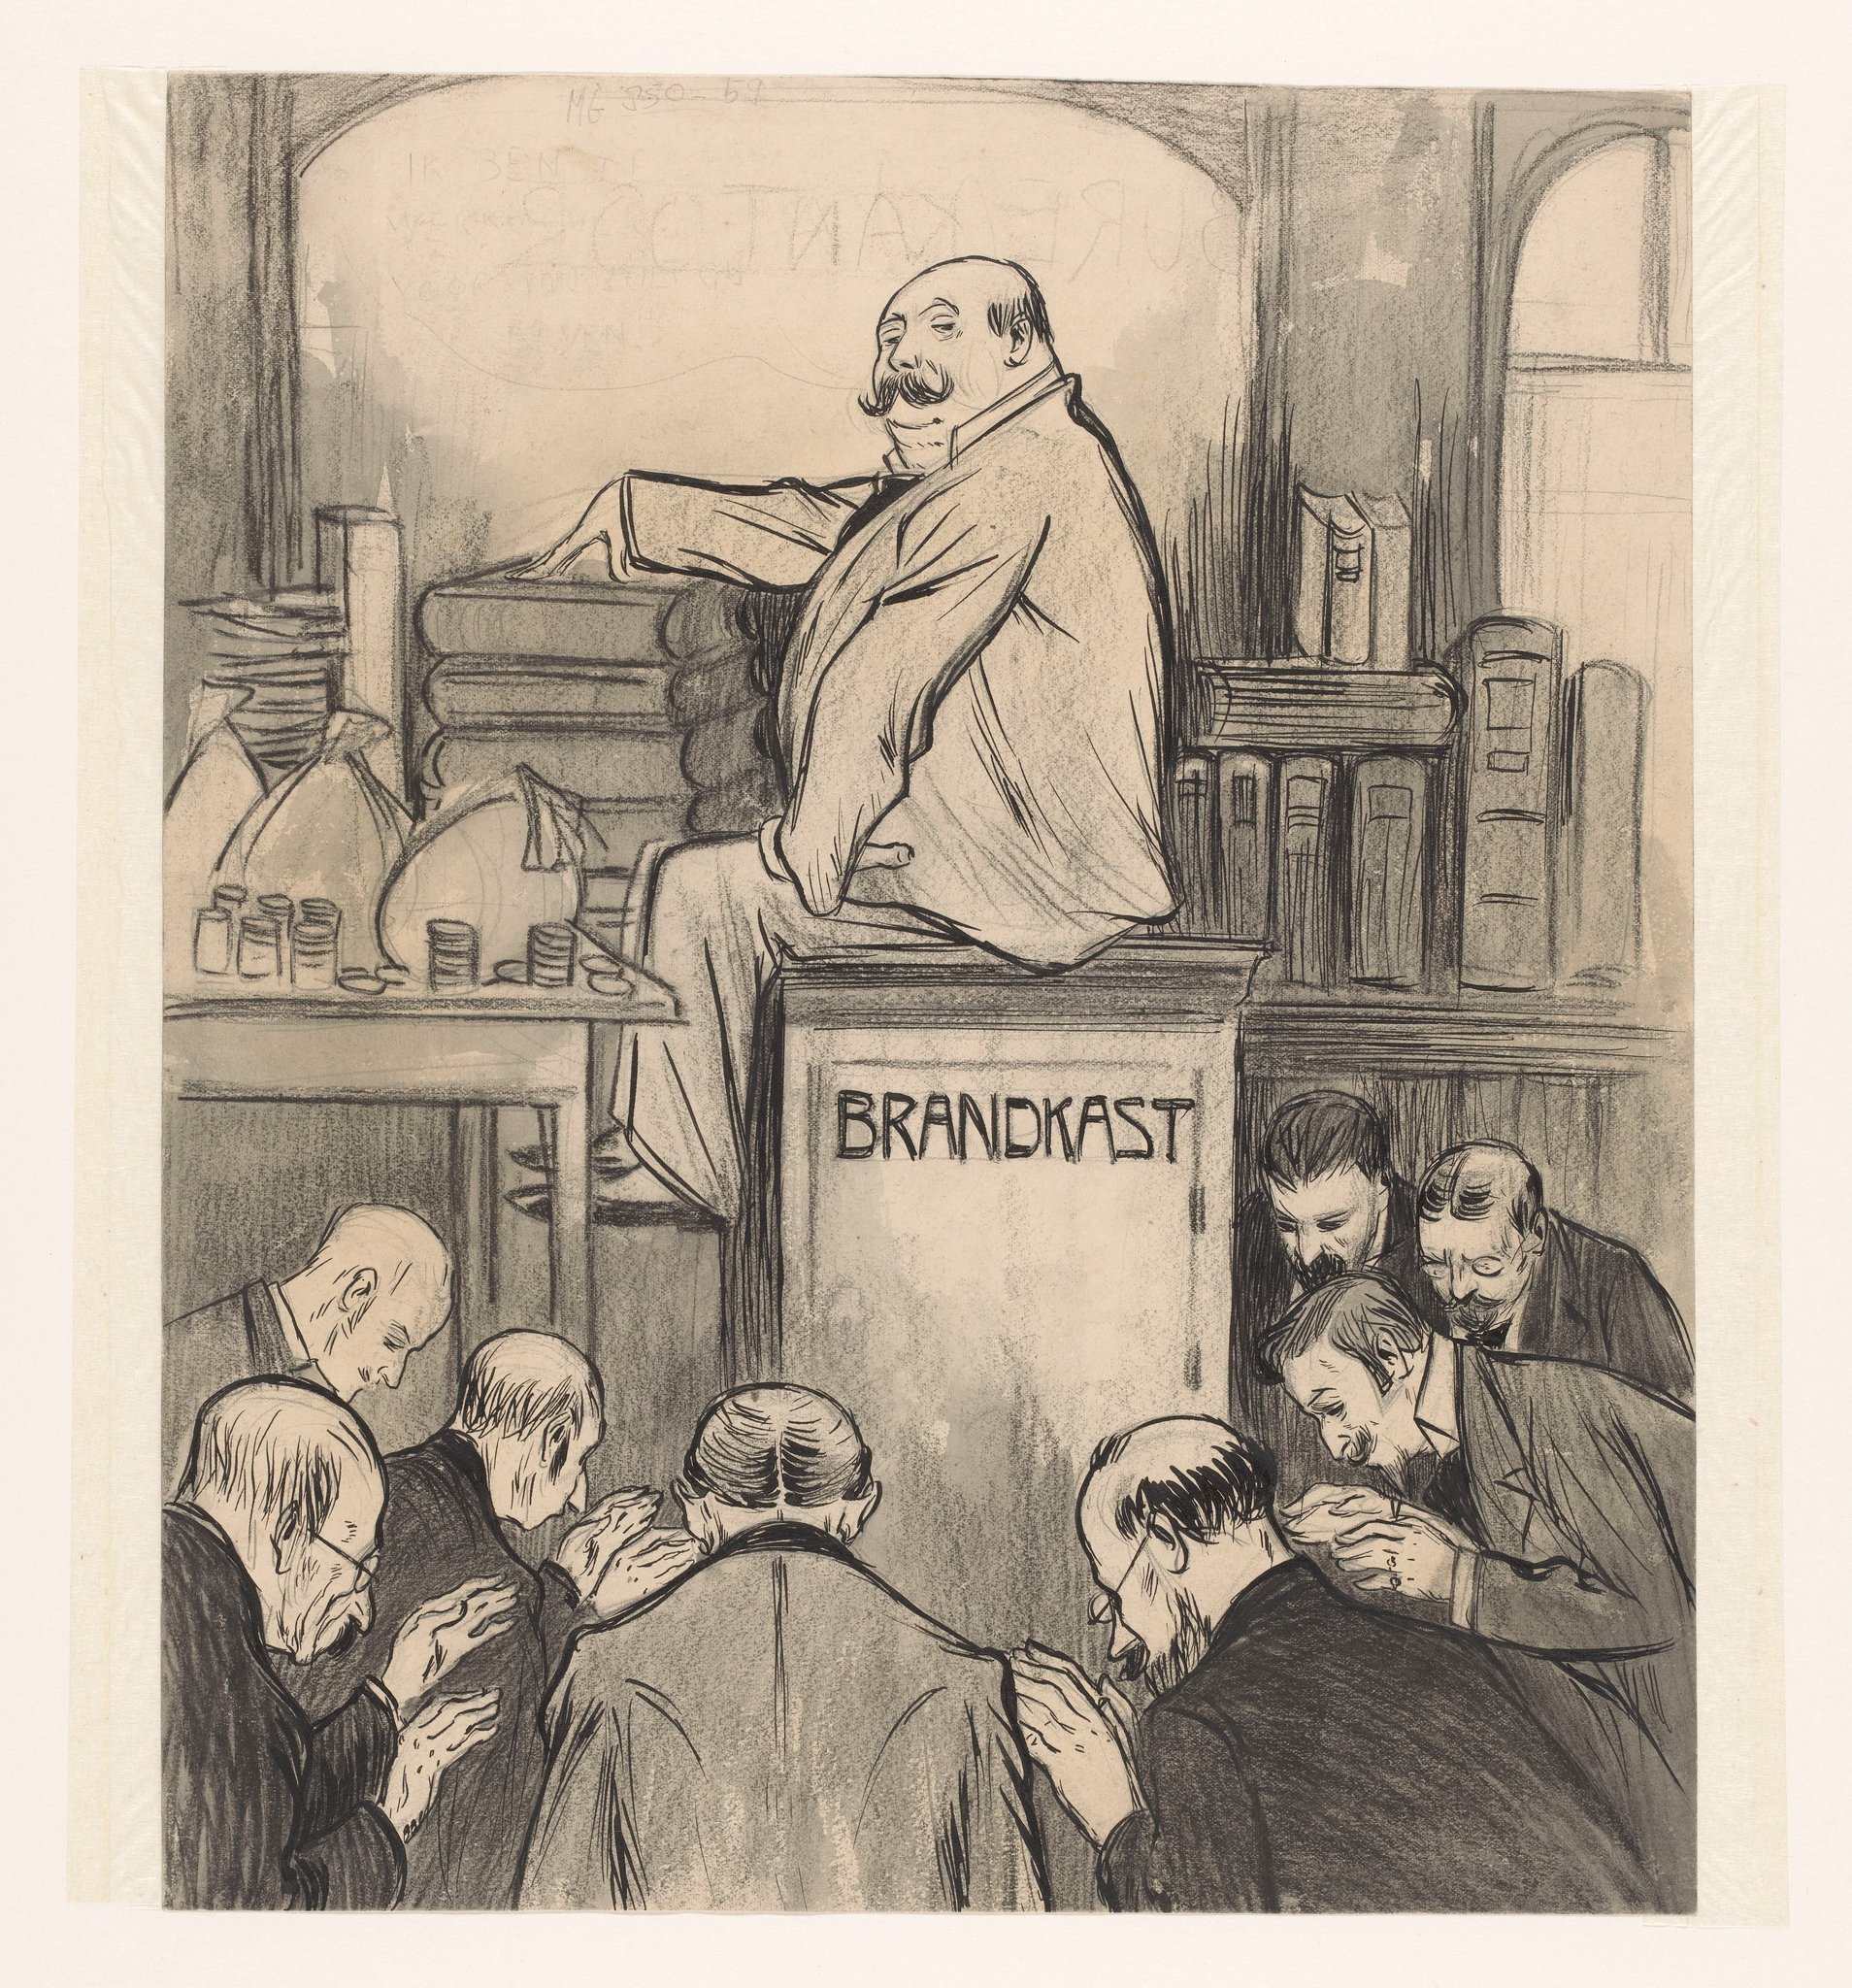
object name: drawing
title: Brandkast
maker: jan de waardt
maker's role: draughtsman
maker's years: 1871-1909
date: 1890-1909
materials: chalk, ink, paper, pencil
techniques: brush, pen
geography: netherlands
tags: protection of wealth, safe, strongbox, netherlands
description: Een dikke heer, directeur of bankier, zit naar links gewend op een brandkast, met de rechterhand op een stapel boeken. Onder buigen mannen nederig voor de brandkast.